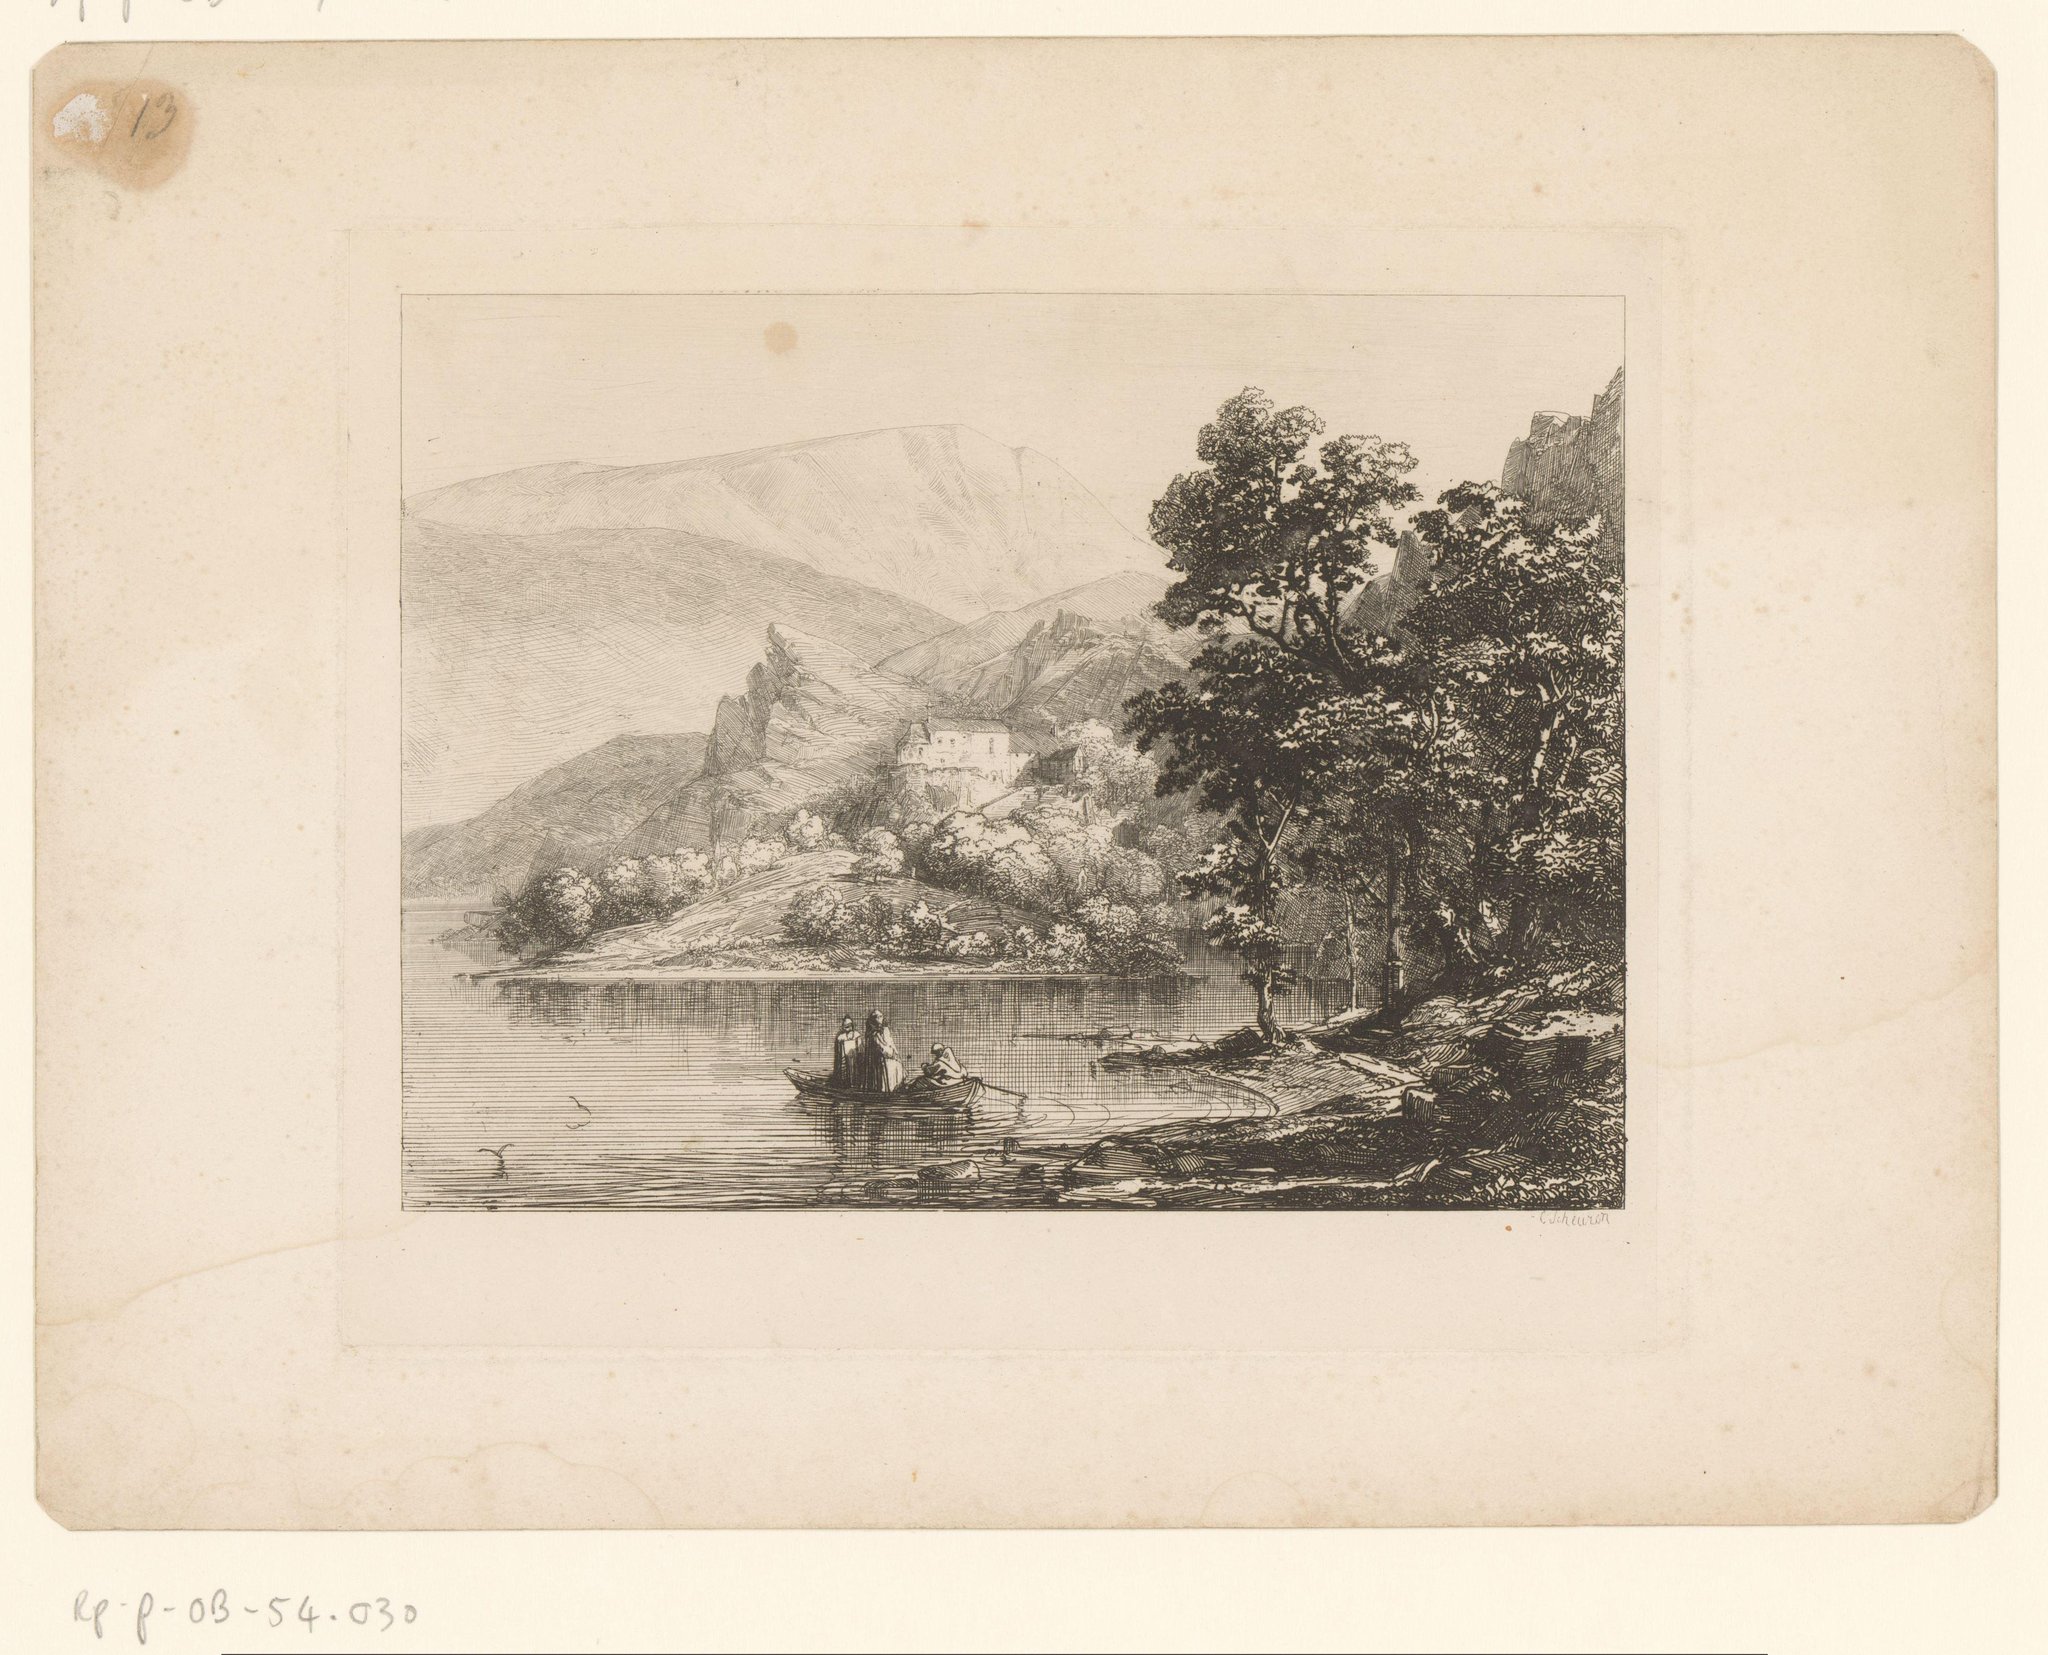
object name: print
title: Etsen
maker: caspar johann nepomuk scheuren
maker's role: draughtsman, print maker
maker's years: 1810-1887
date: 1842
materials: paper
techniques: etching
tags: landscapes with waters, waterscapes, seascapes (in the temperate zone), monk(s), friar(s), cloisters ~ monastery, mountains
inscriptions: collector's mark: Lugt 2228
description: Prent onderdeel van een serie van twaalf bladen met etsen.